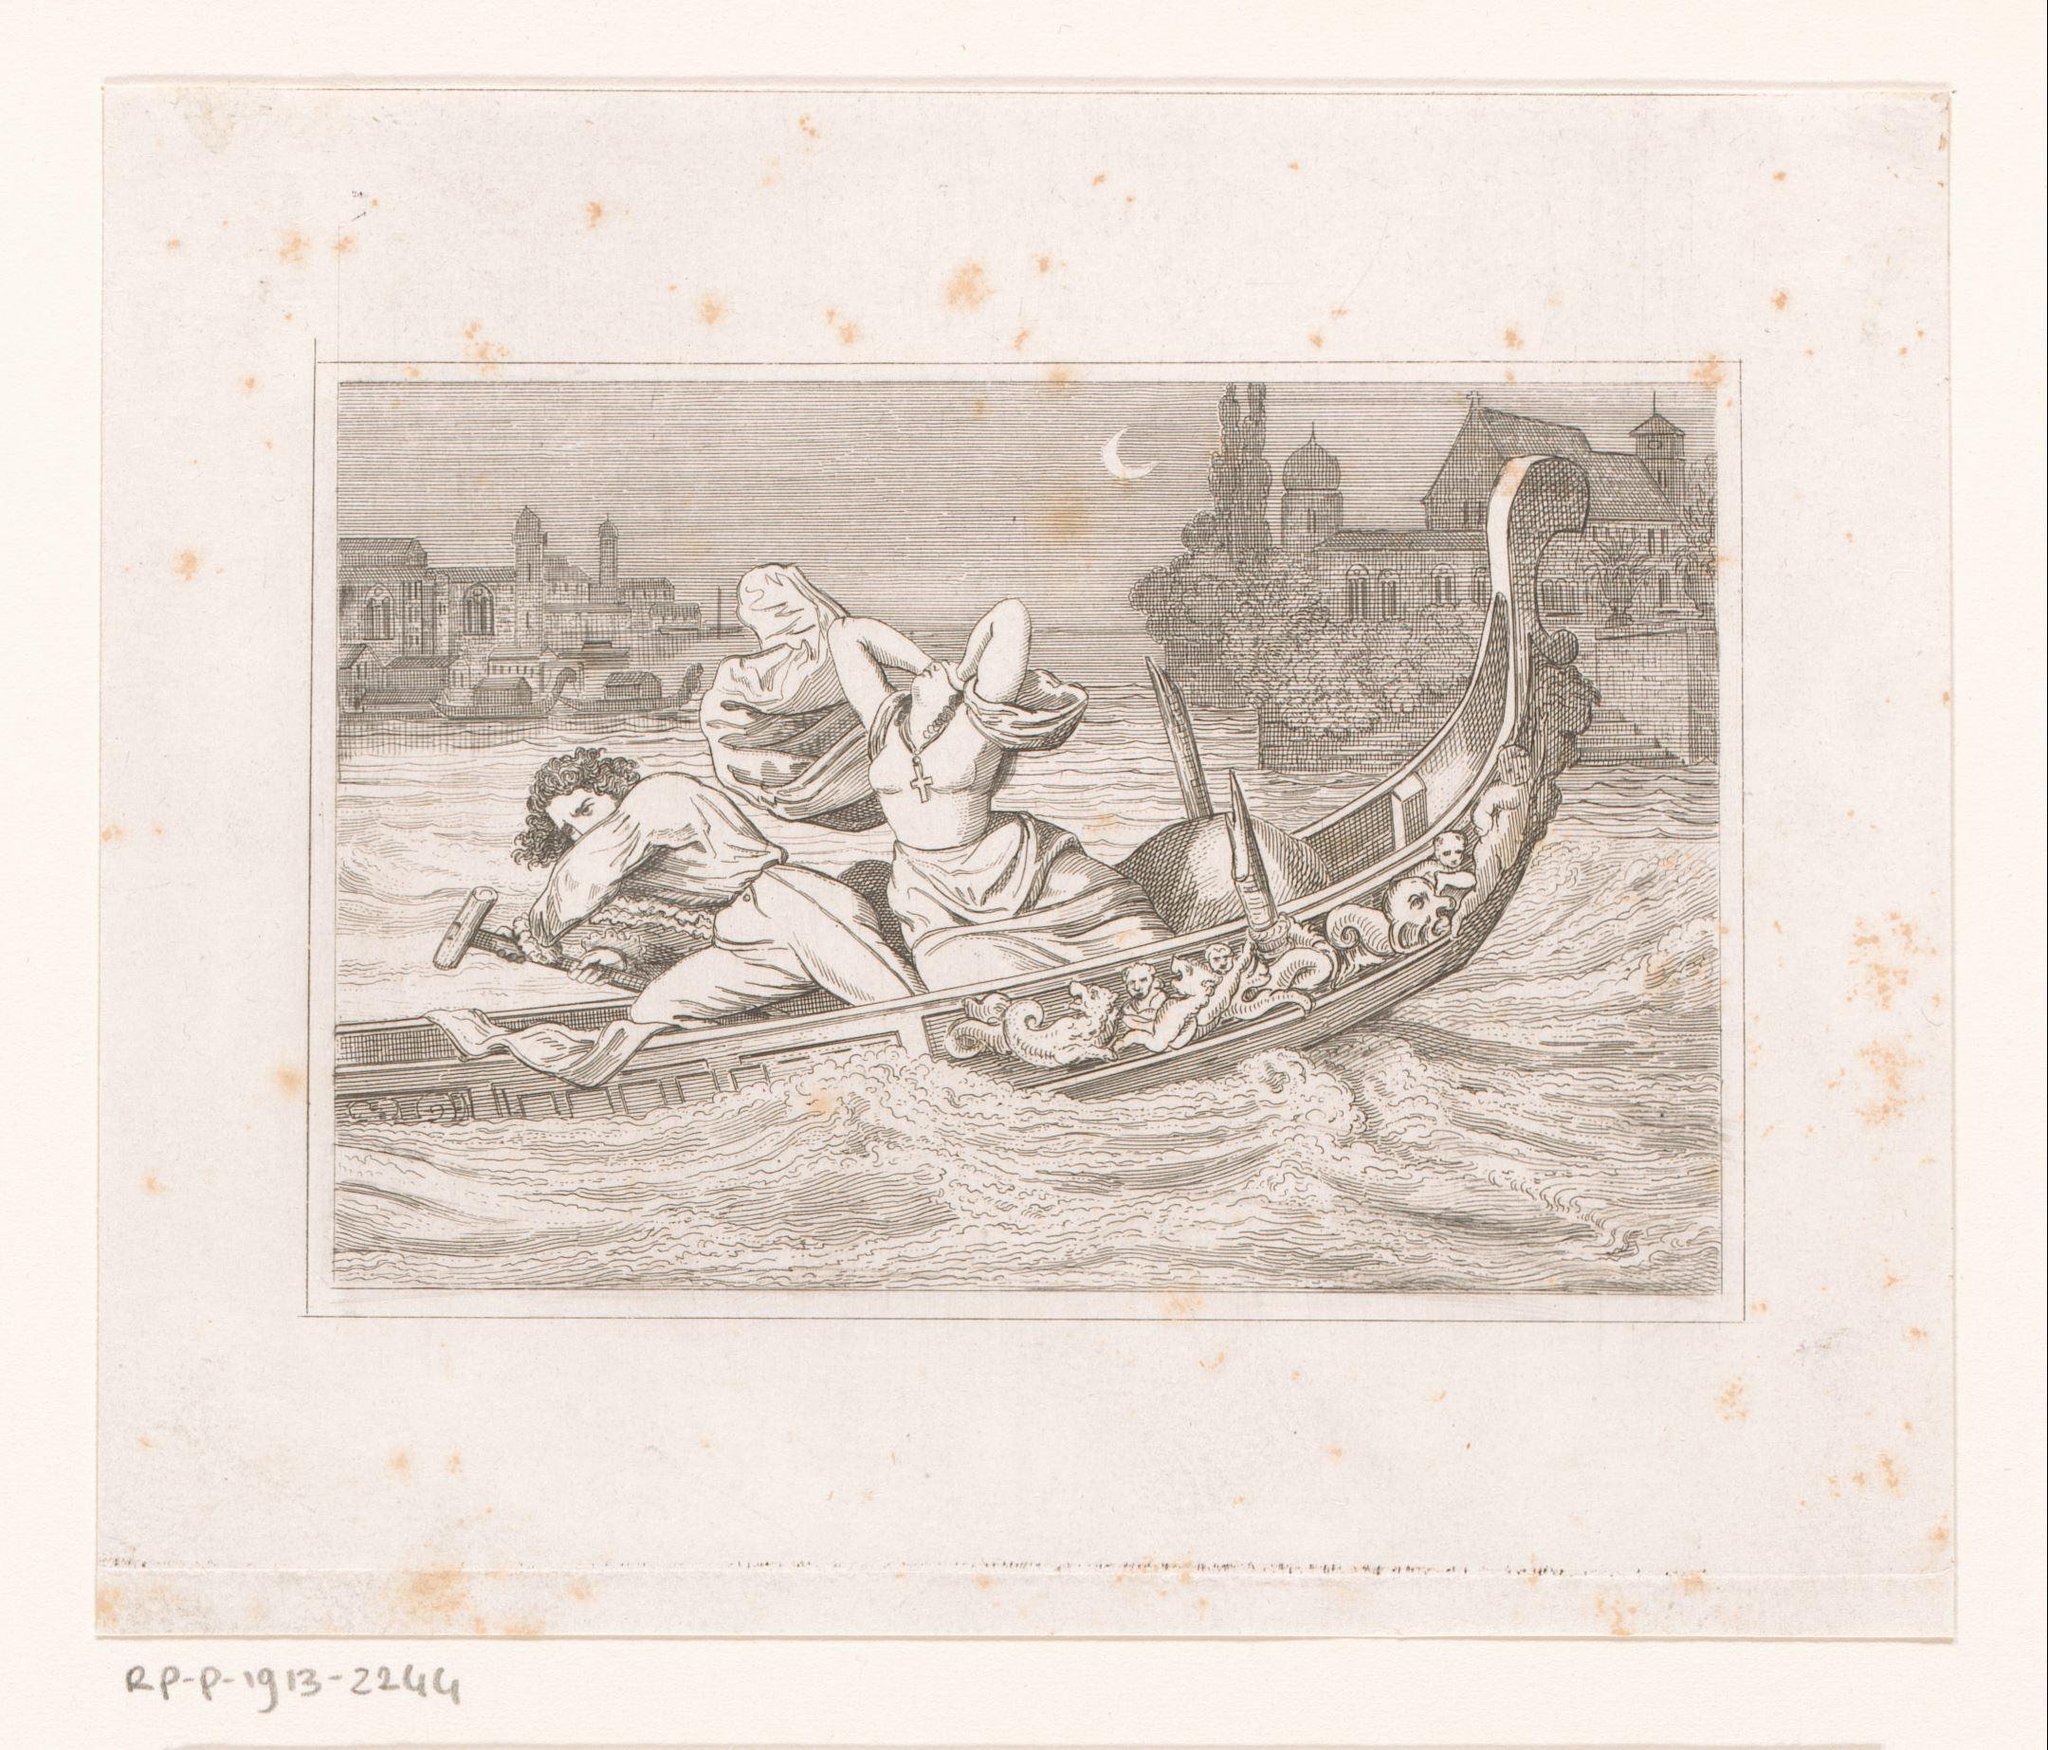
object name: print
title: Scènes uit een roman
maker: auguste numans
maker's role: print maker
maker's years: 1823-1883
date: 1833-1880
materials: paper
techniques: etching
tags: wave, waning moon, i.e. facing this way (, gondola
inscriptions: collector's mark: Lugt 2228